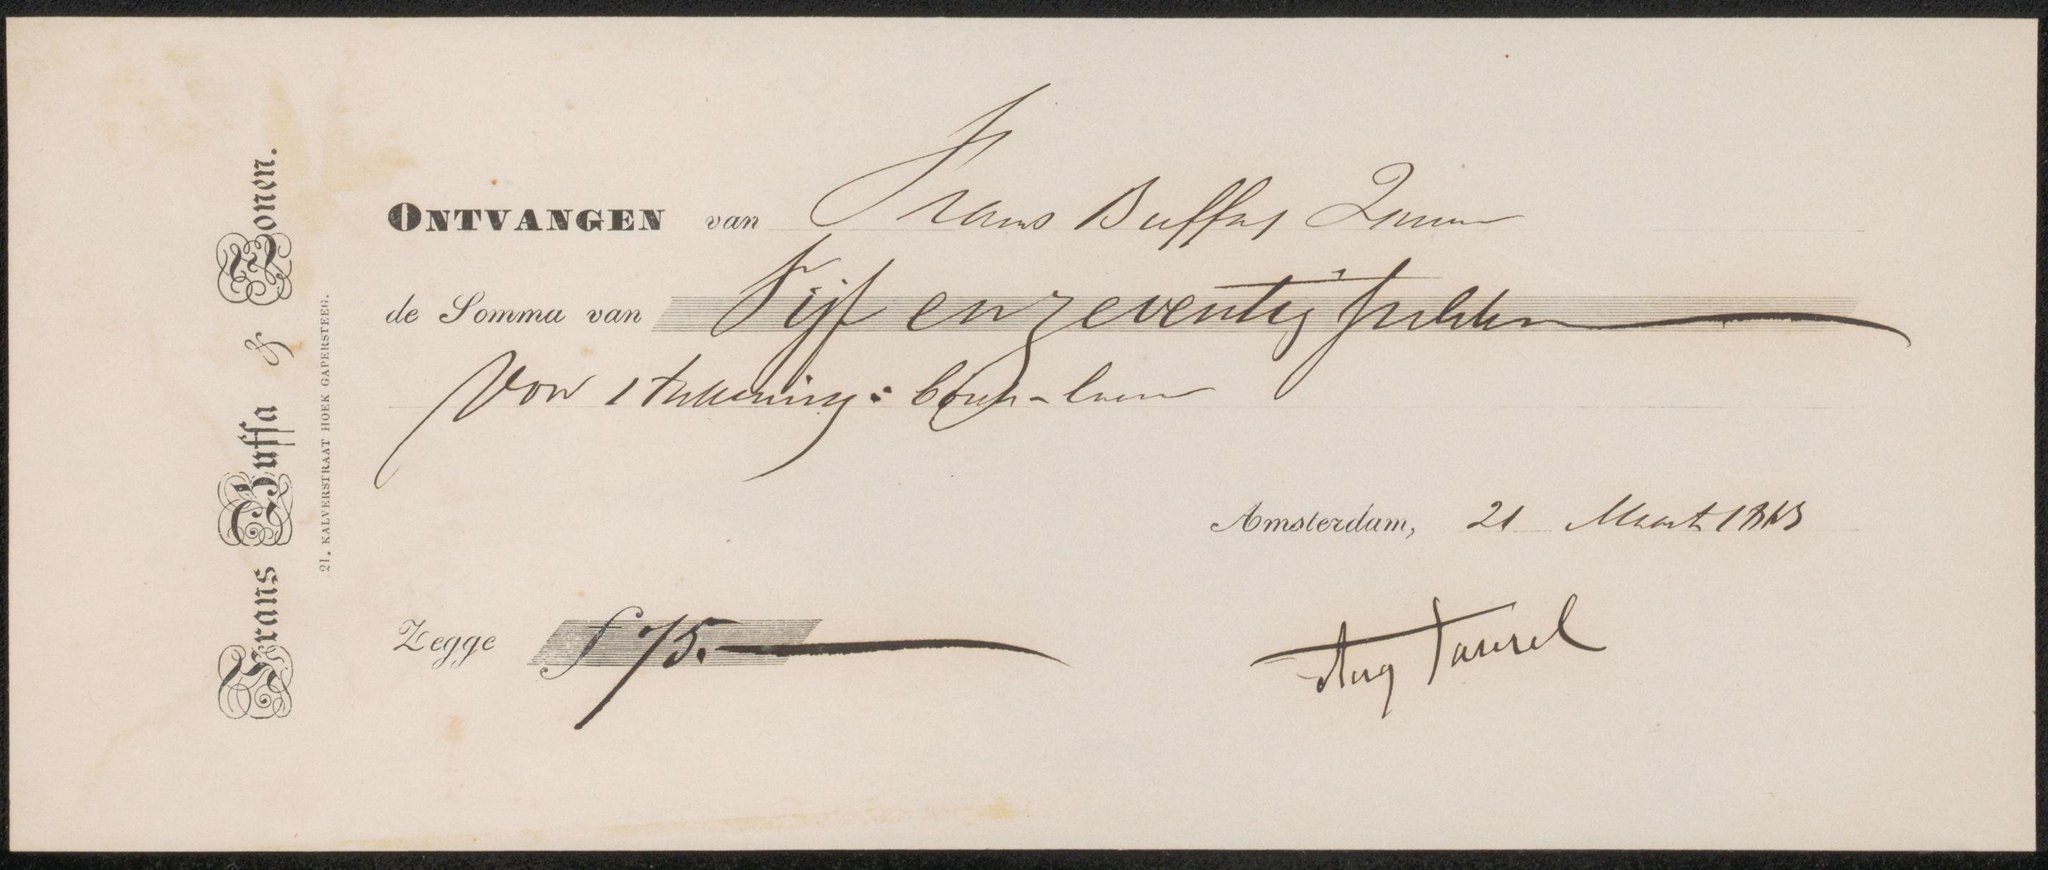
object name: ontvangstbewijs, kwitantie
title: Kwitantie voor Augustin Taurel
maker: augustin taurel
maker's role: draughtsman, print maker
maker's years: 1828-1879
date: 1863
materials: ink, paper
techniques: pen, printing, writing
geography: amsterdam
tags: drawing, money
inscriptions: collector's mark: Lugt 2233